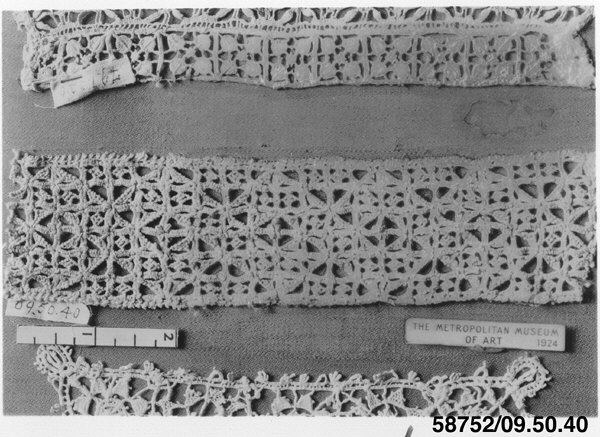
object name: strip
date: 1501-1700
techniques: lace